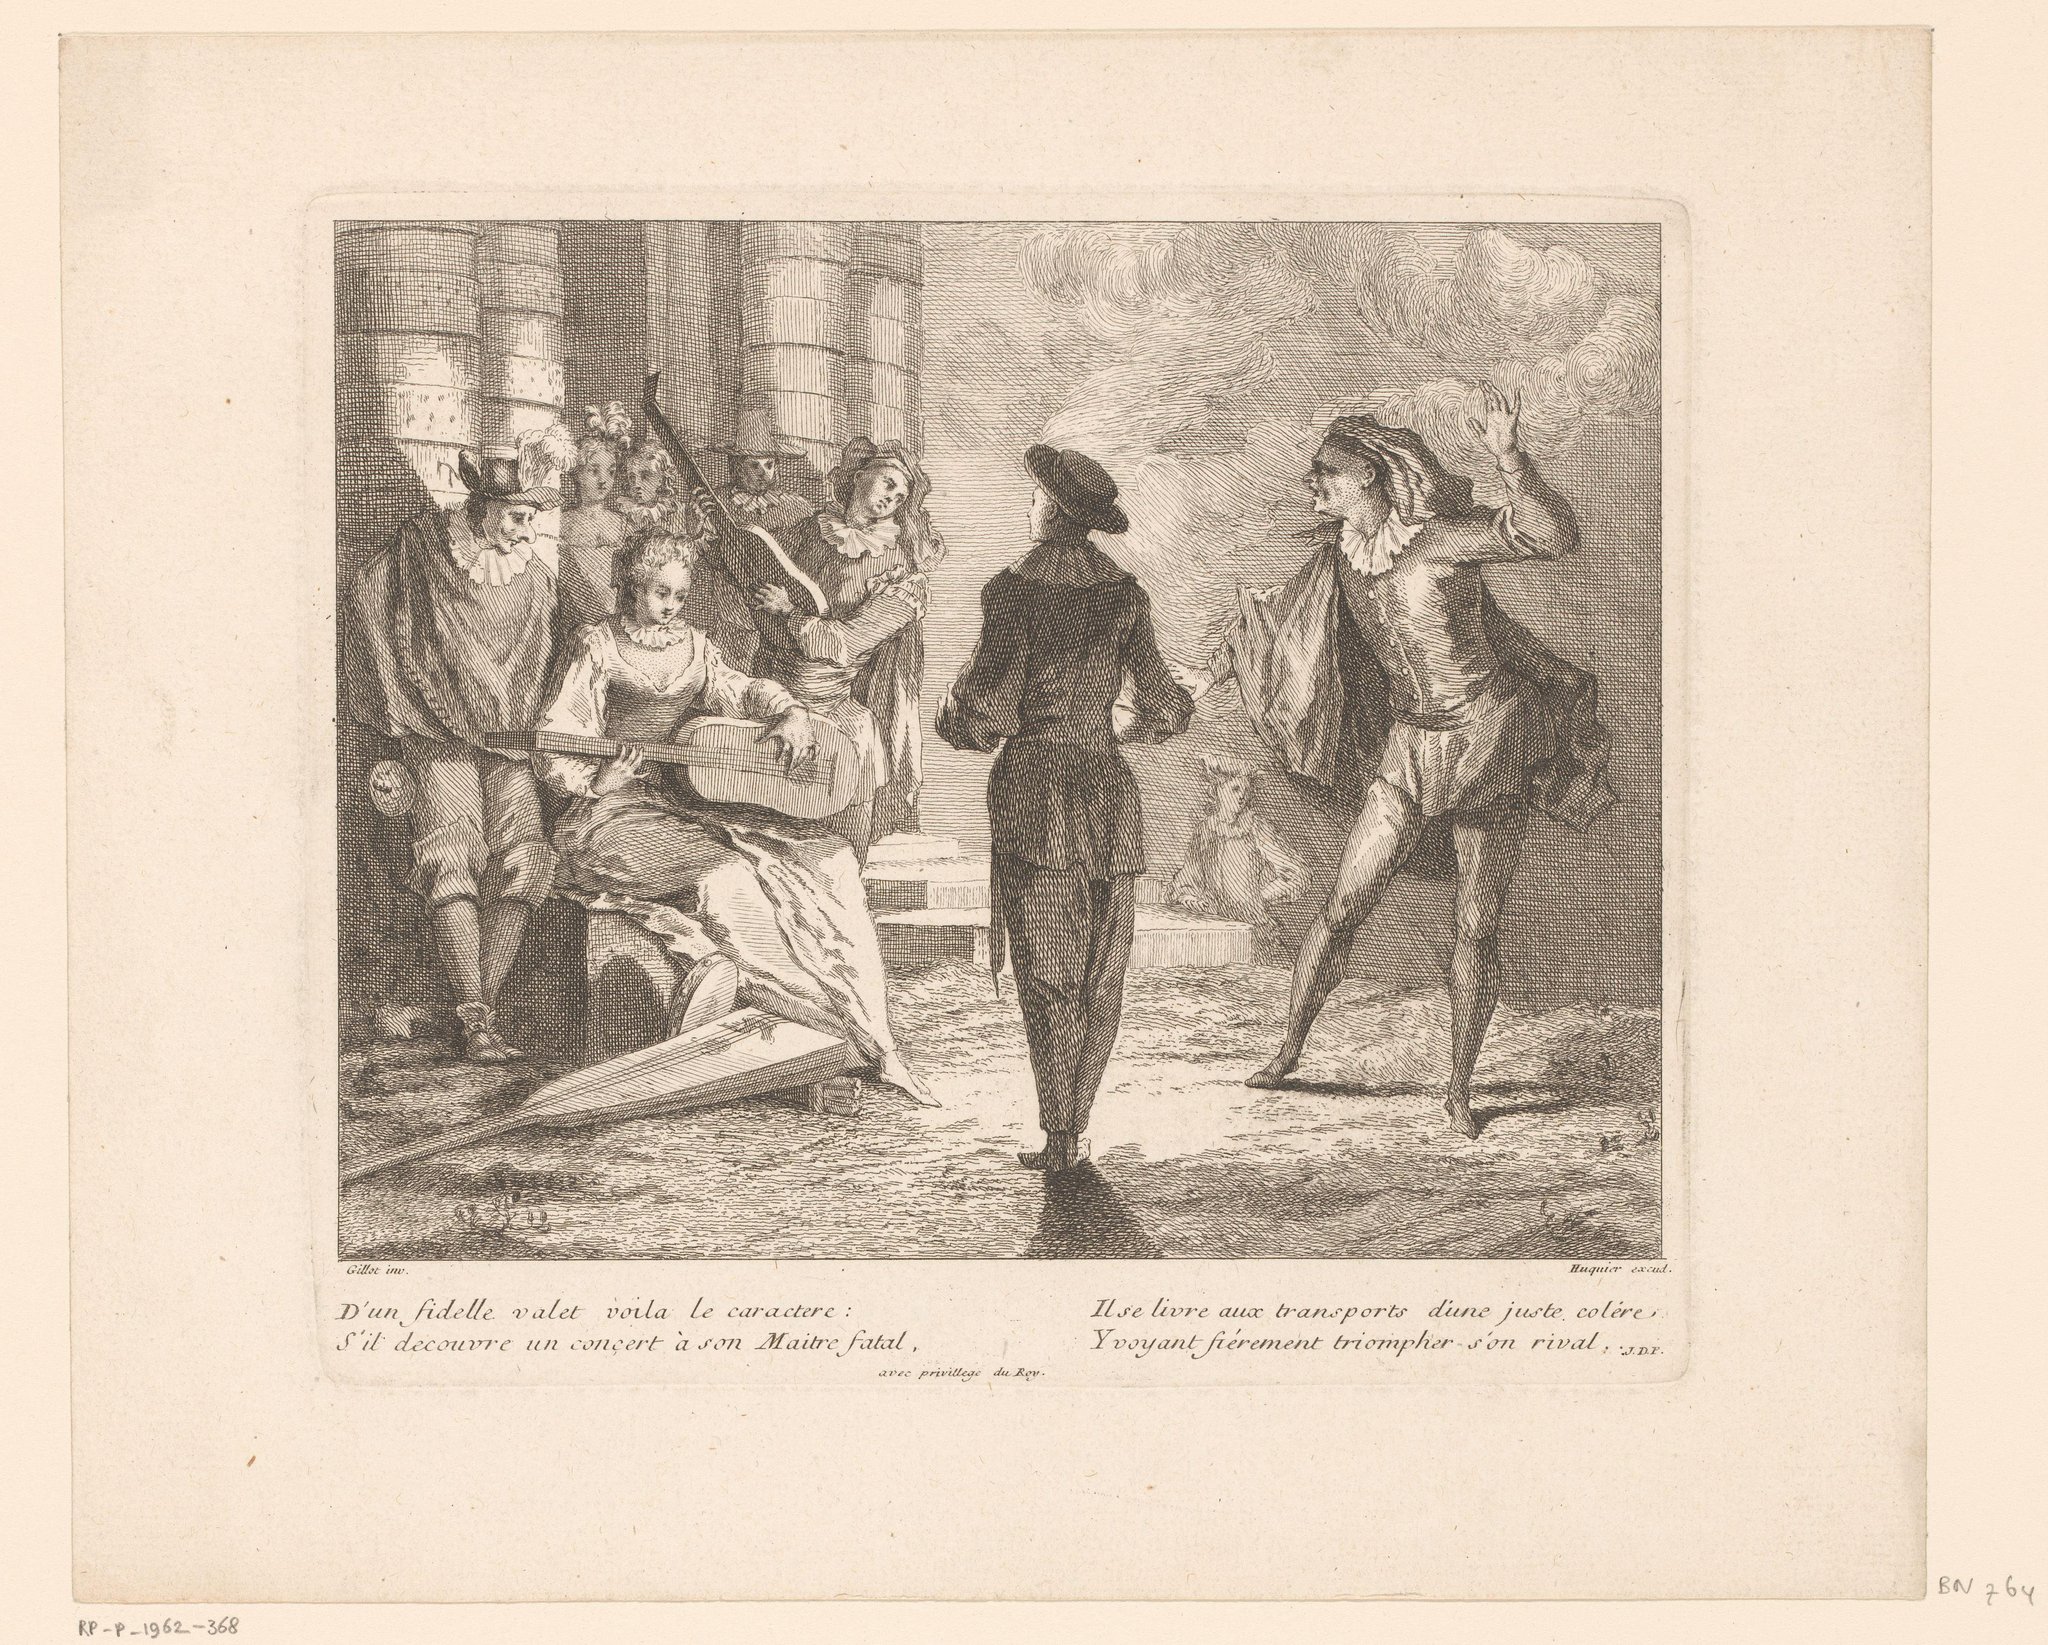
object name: print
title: Scènes uit de Commedia dell'arte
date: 1729-1732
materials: paper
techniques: etching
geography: france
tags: types in 'commedia dell'arte': pierrot, 'commedia dell'arte'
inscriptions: collector's mark: Lugt 2228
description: Maakt deel uit van een serie van twaalf prenten met scènes uit de Commedia dell'arte door Huquier naar tekeningen door Gillot. De serie werd tussen 1729 en 1732 uitgegeven door Huquier en de weduwe van François Chéreau.